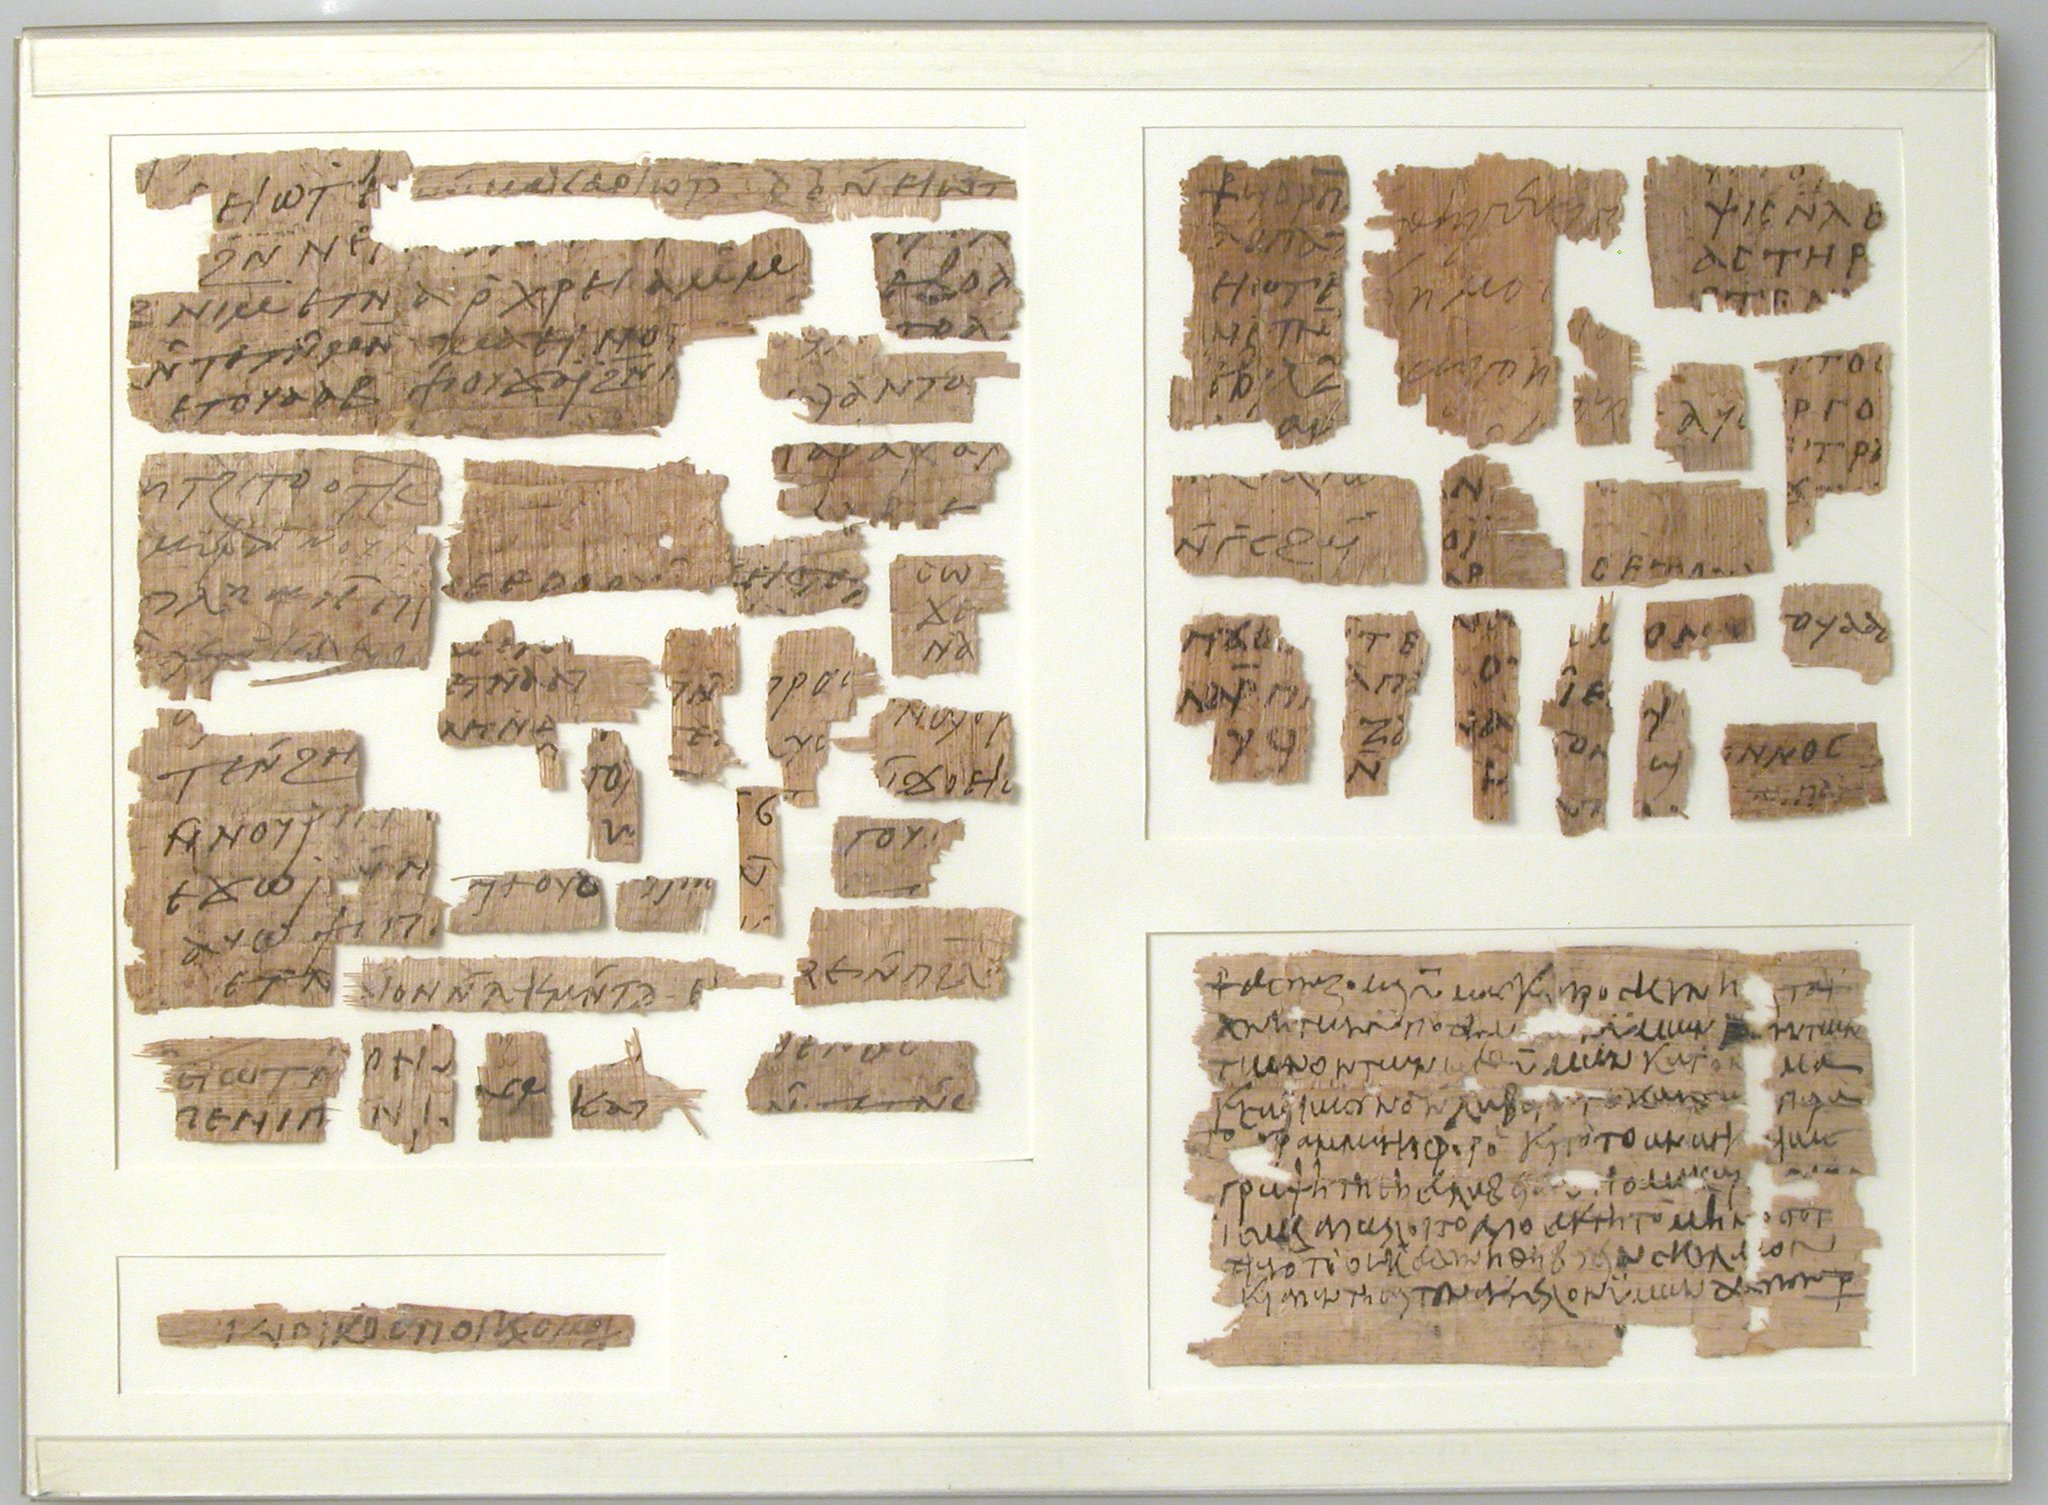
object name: fragment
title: Papyri Fragments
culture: coptic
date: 601-700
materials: ink, papyrus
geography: egypt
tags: documents